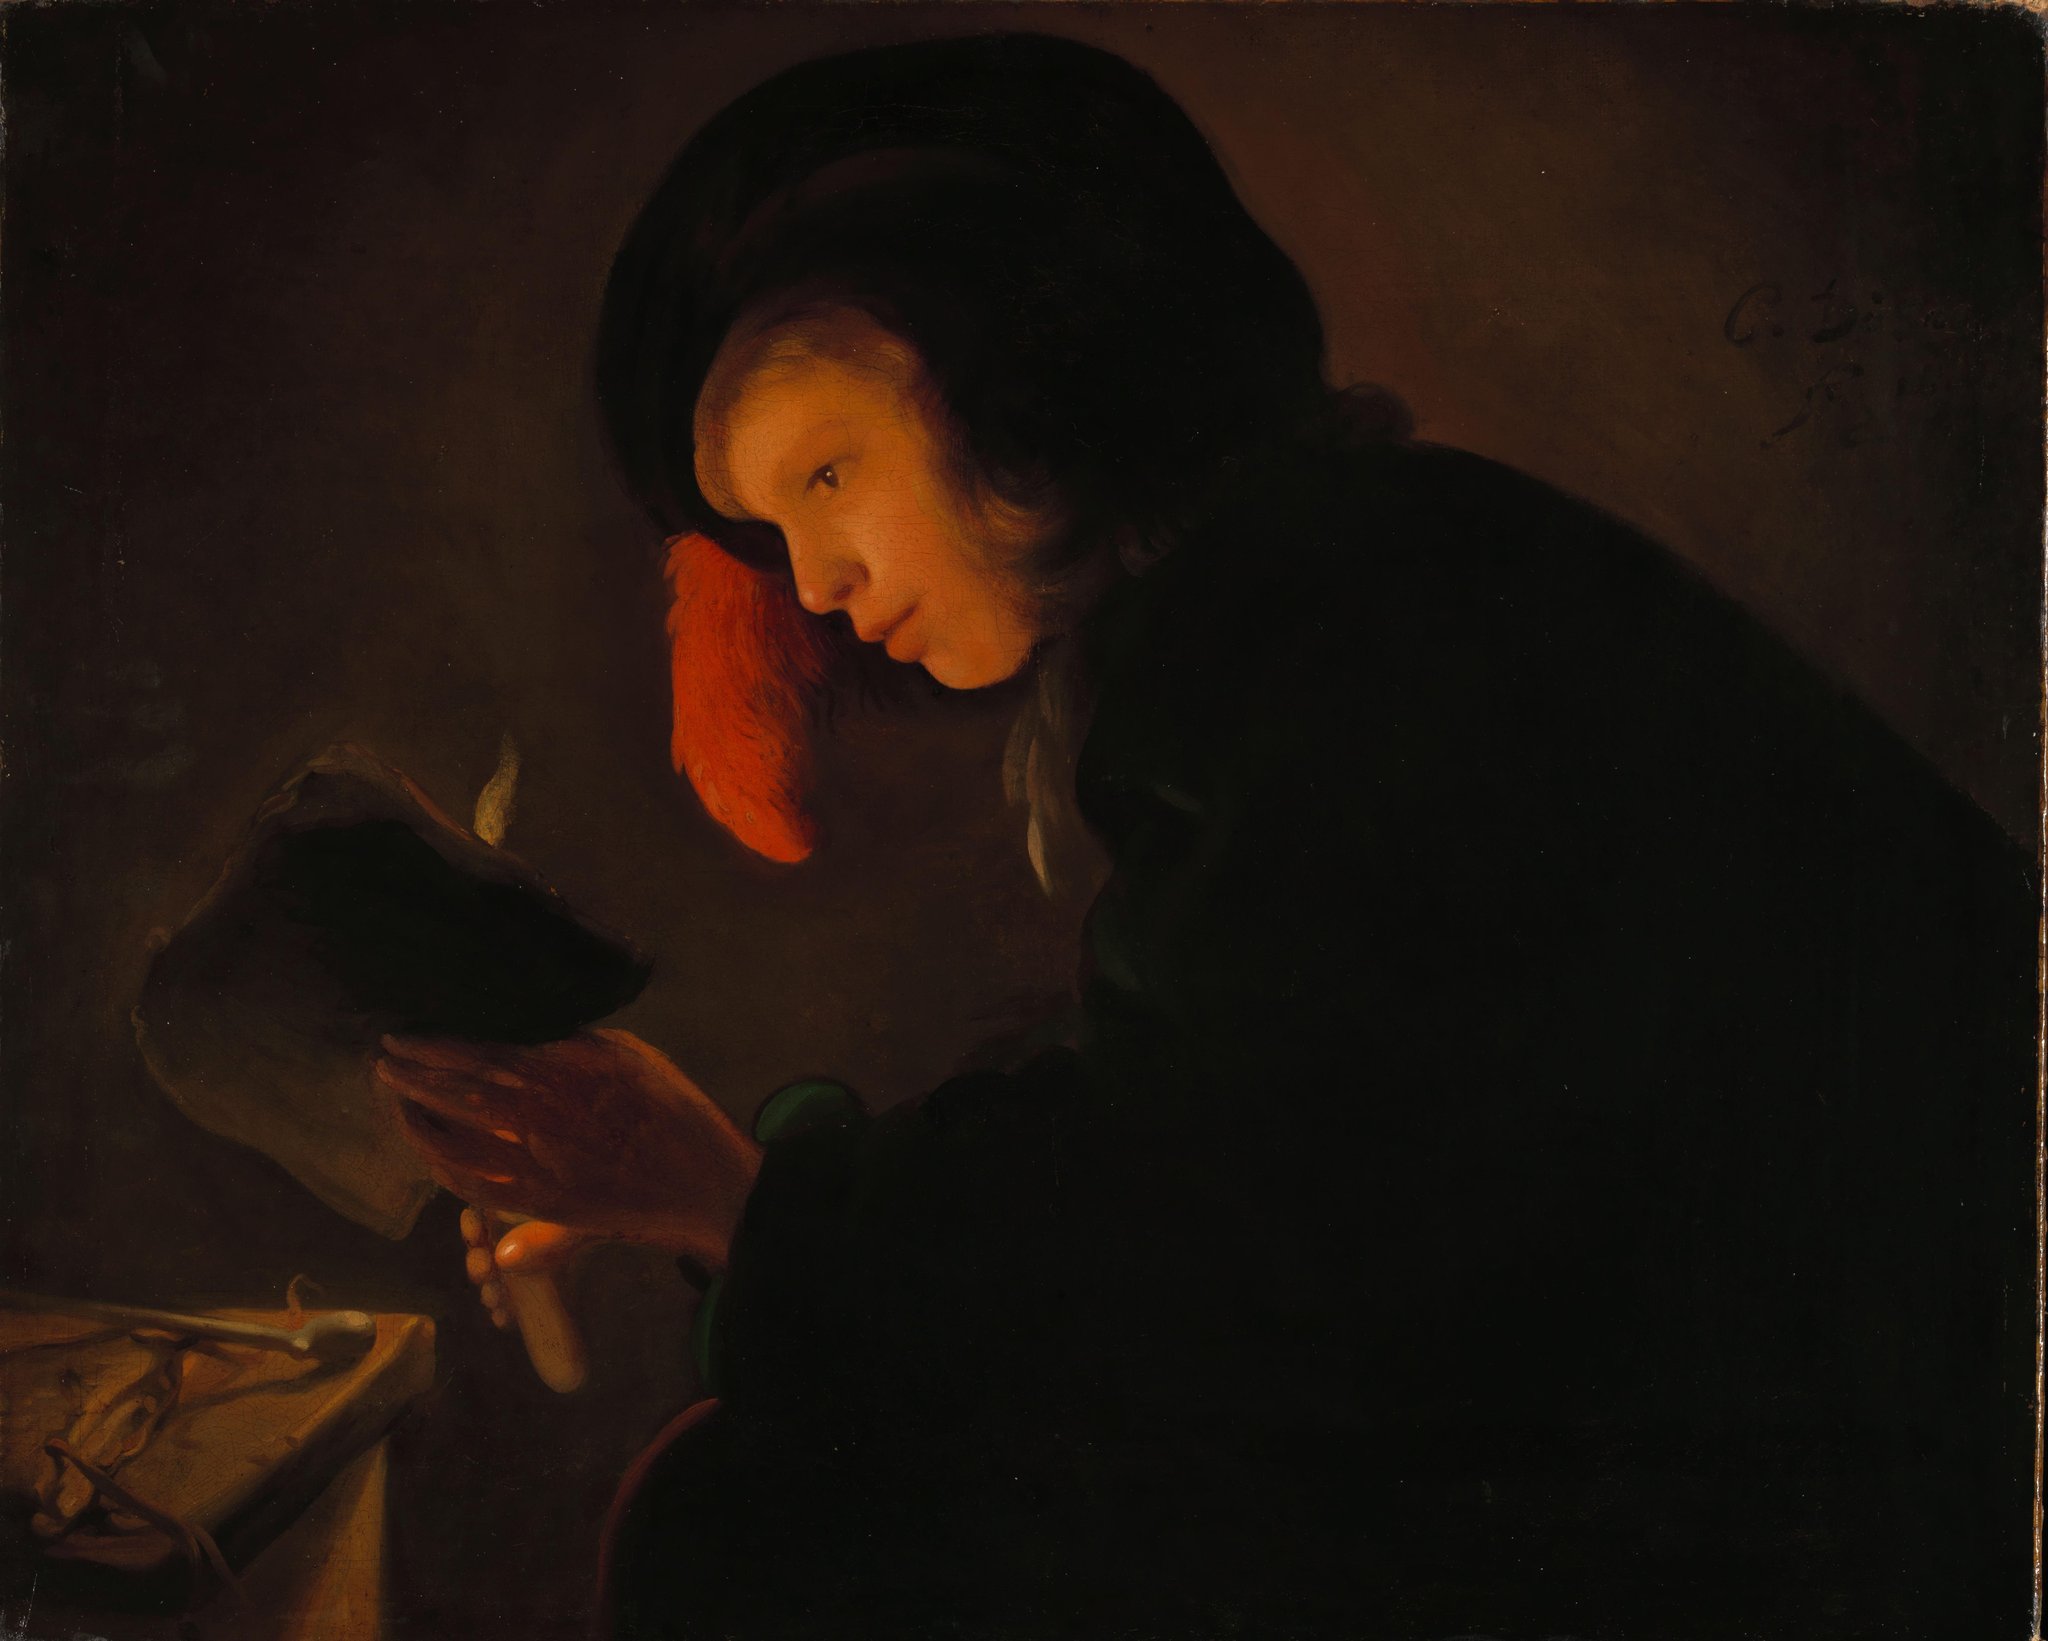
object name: painting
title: Young Man by Candlelight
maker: christiaen jansz. dusart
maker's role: painter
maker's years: 1618-1683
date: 1645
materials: canvas, oil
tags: reading, candle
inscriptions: signature and date: ‘C. Dusart fe. 1645’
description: Jonge man bij kaarslicht. Een jongen leest een blad papier bij het licht van een kaars, op een tafel voor hem ligt een pijp.